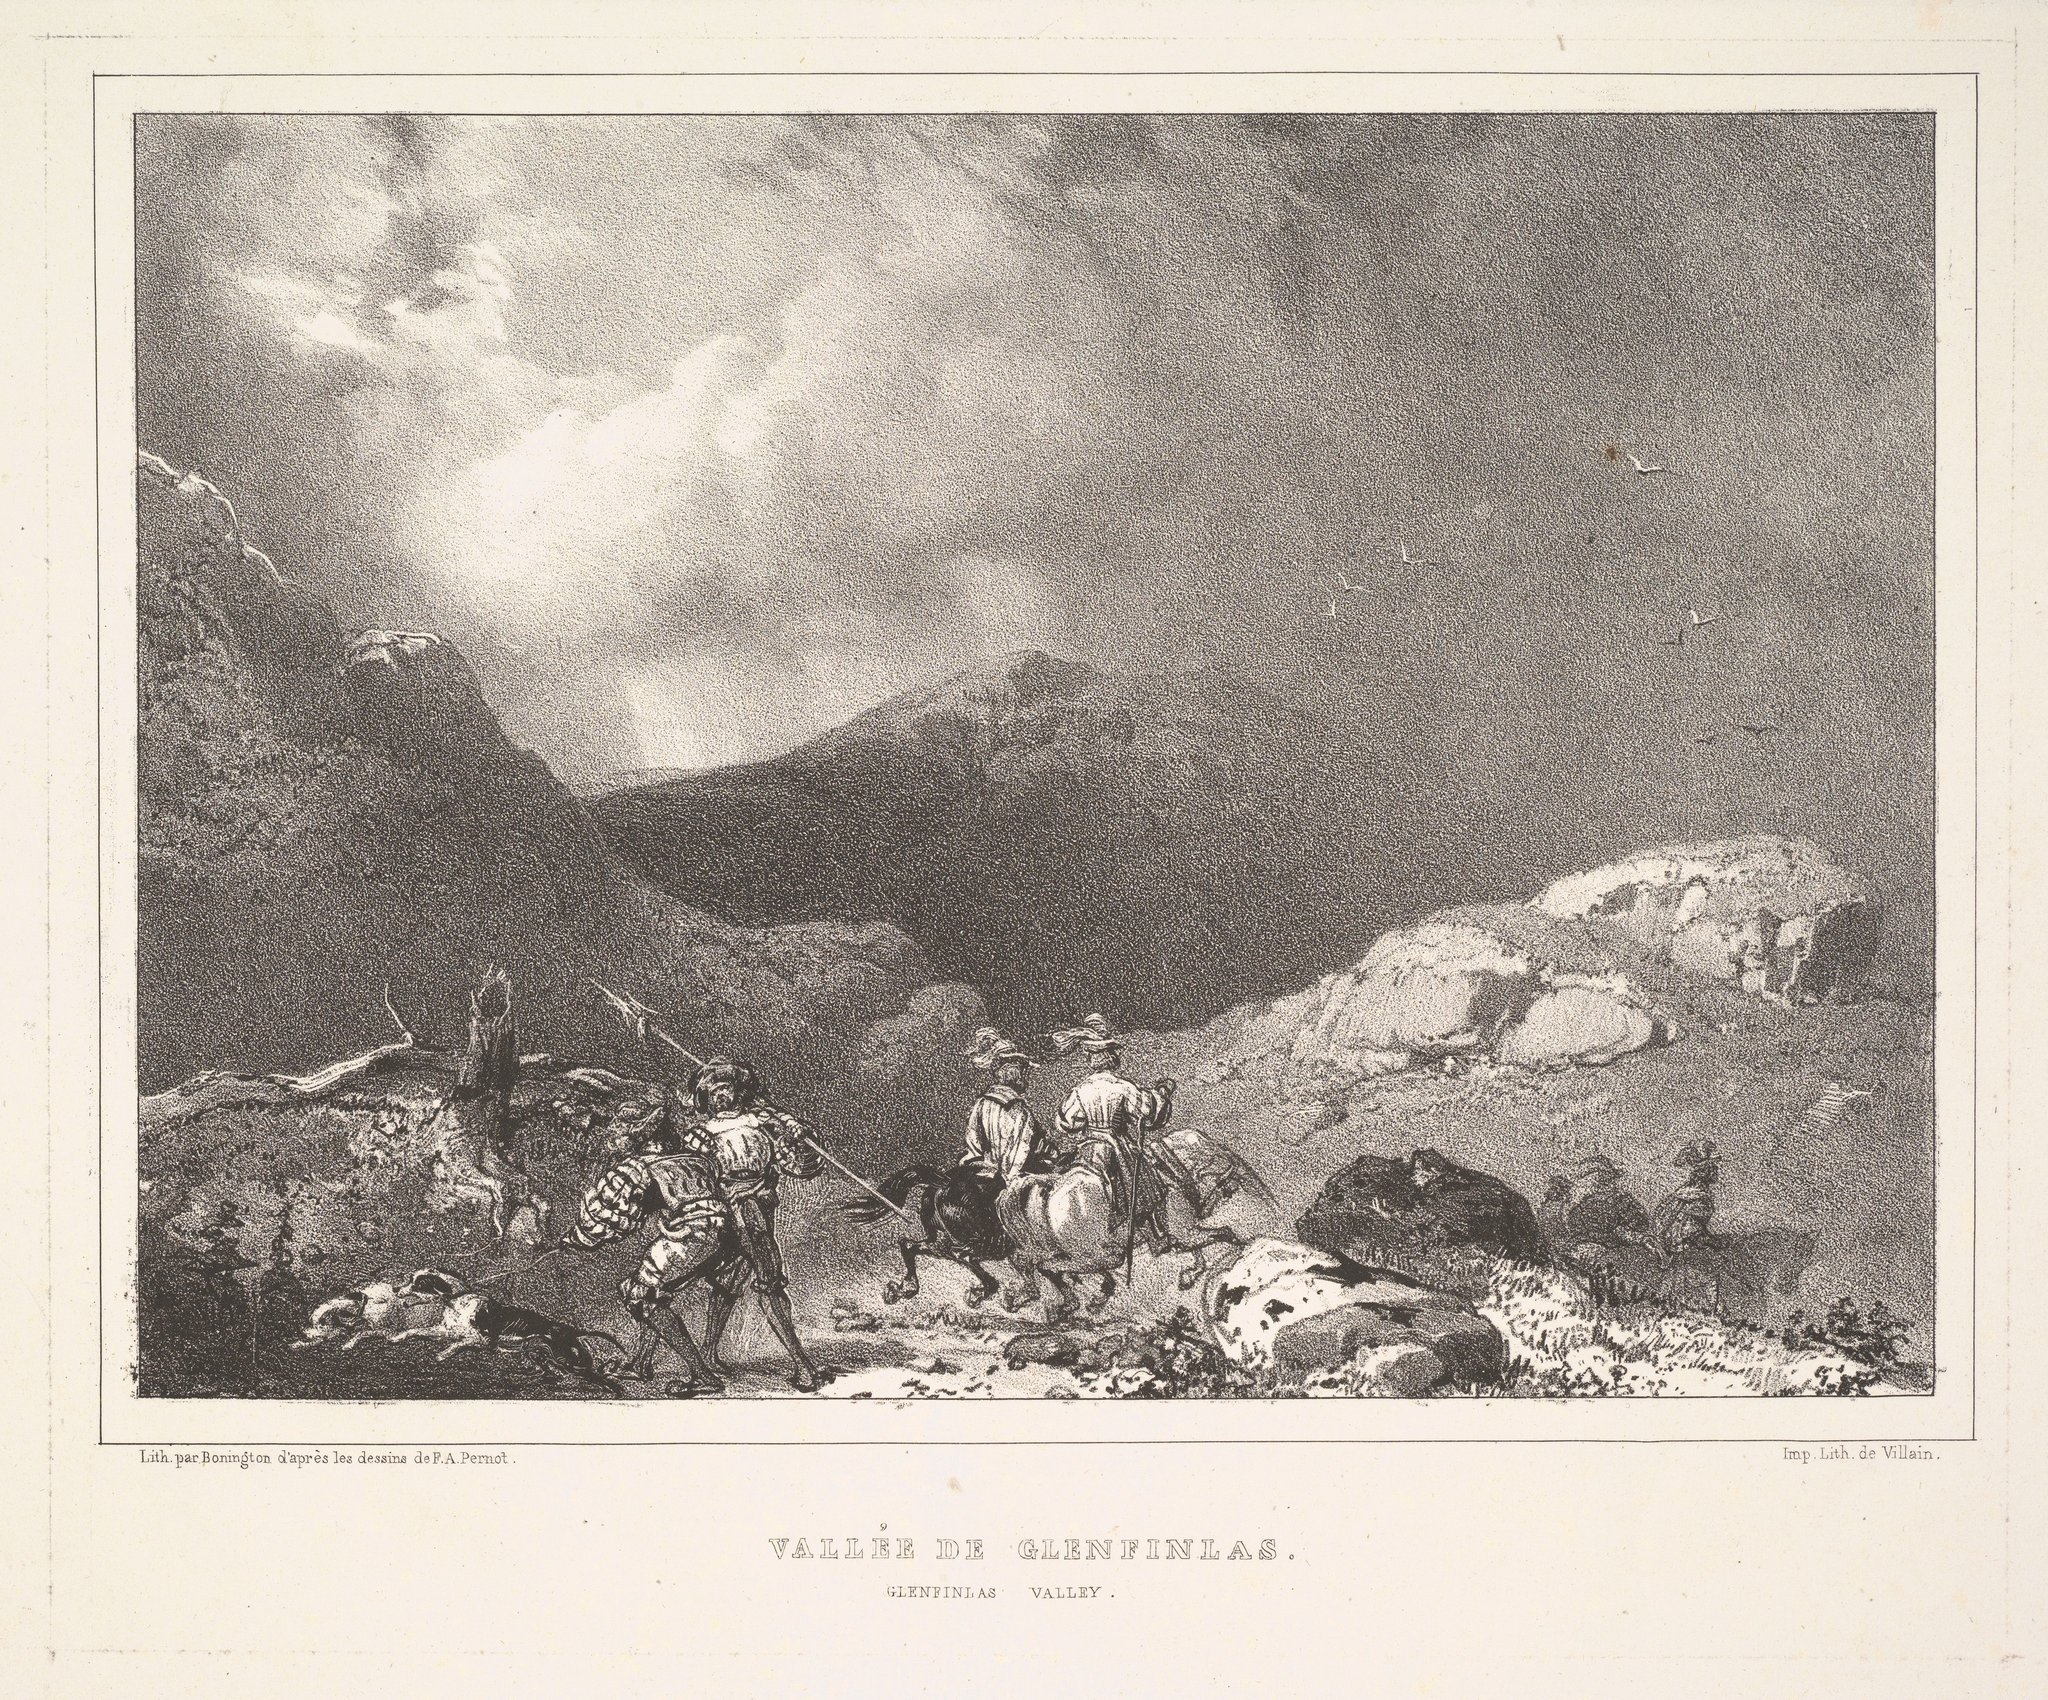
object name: print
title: Vallée de Glenfinlas (Glenfinlas Valley), from "Vues Pittoresques de l'Écosse"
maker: richard parkes bonington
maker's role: artist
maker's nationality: british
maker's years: 1802-1828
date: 1826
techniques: lithograph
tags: soldiers,men,horses,mountains